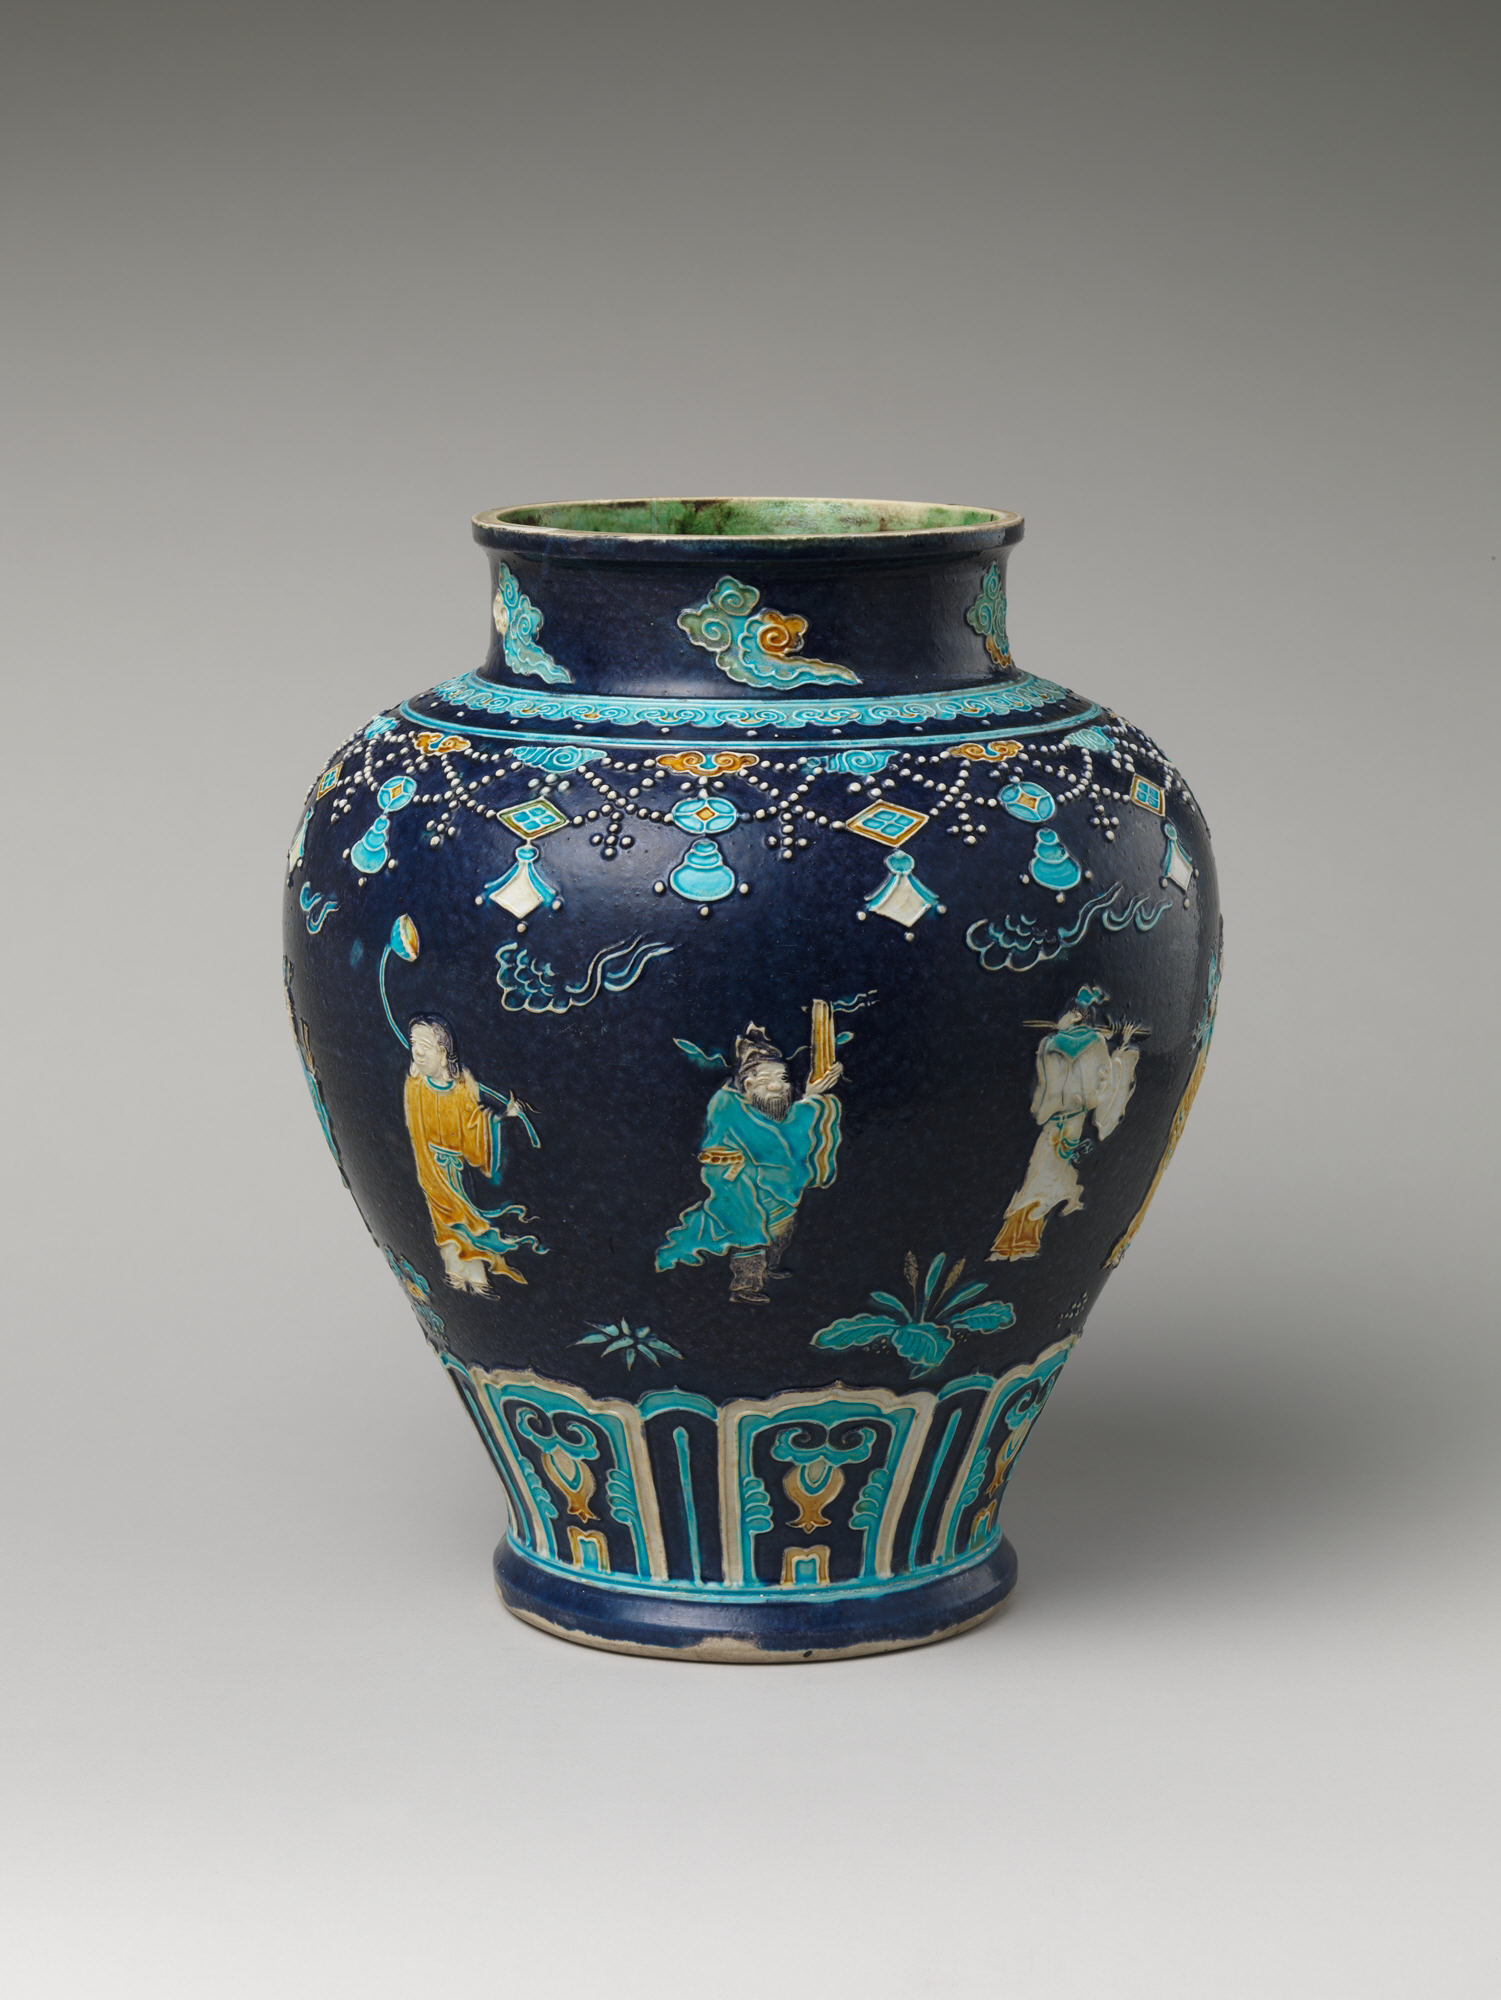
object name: jar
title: Jar with immortals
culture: chinese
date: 1467-1500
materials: enamel, porcelain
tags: human figures